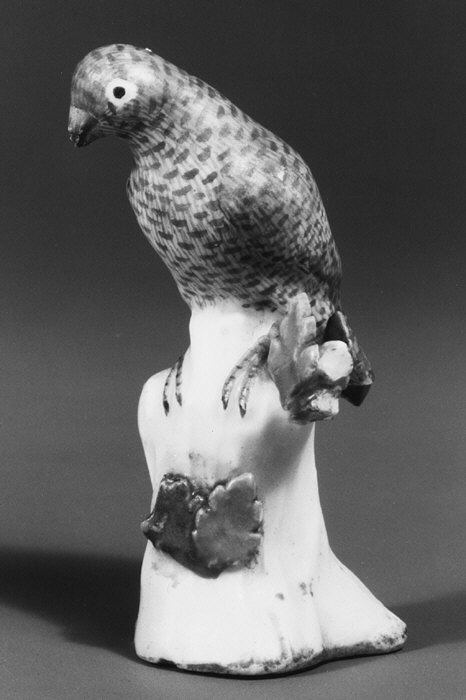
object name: figure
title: Miniature figure of a parakeet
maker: meissen manufactory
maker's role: manufactory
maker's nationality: german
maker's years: 1710-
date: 1745-1750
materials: hard paste porcelain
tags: birds